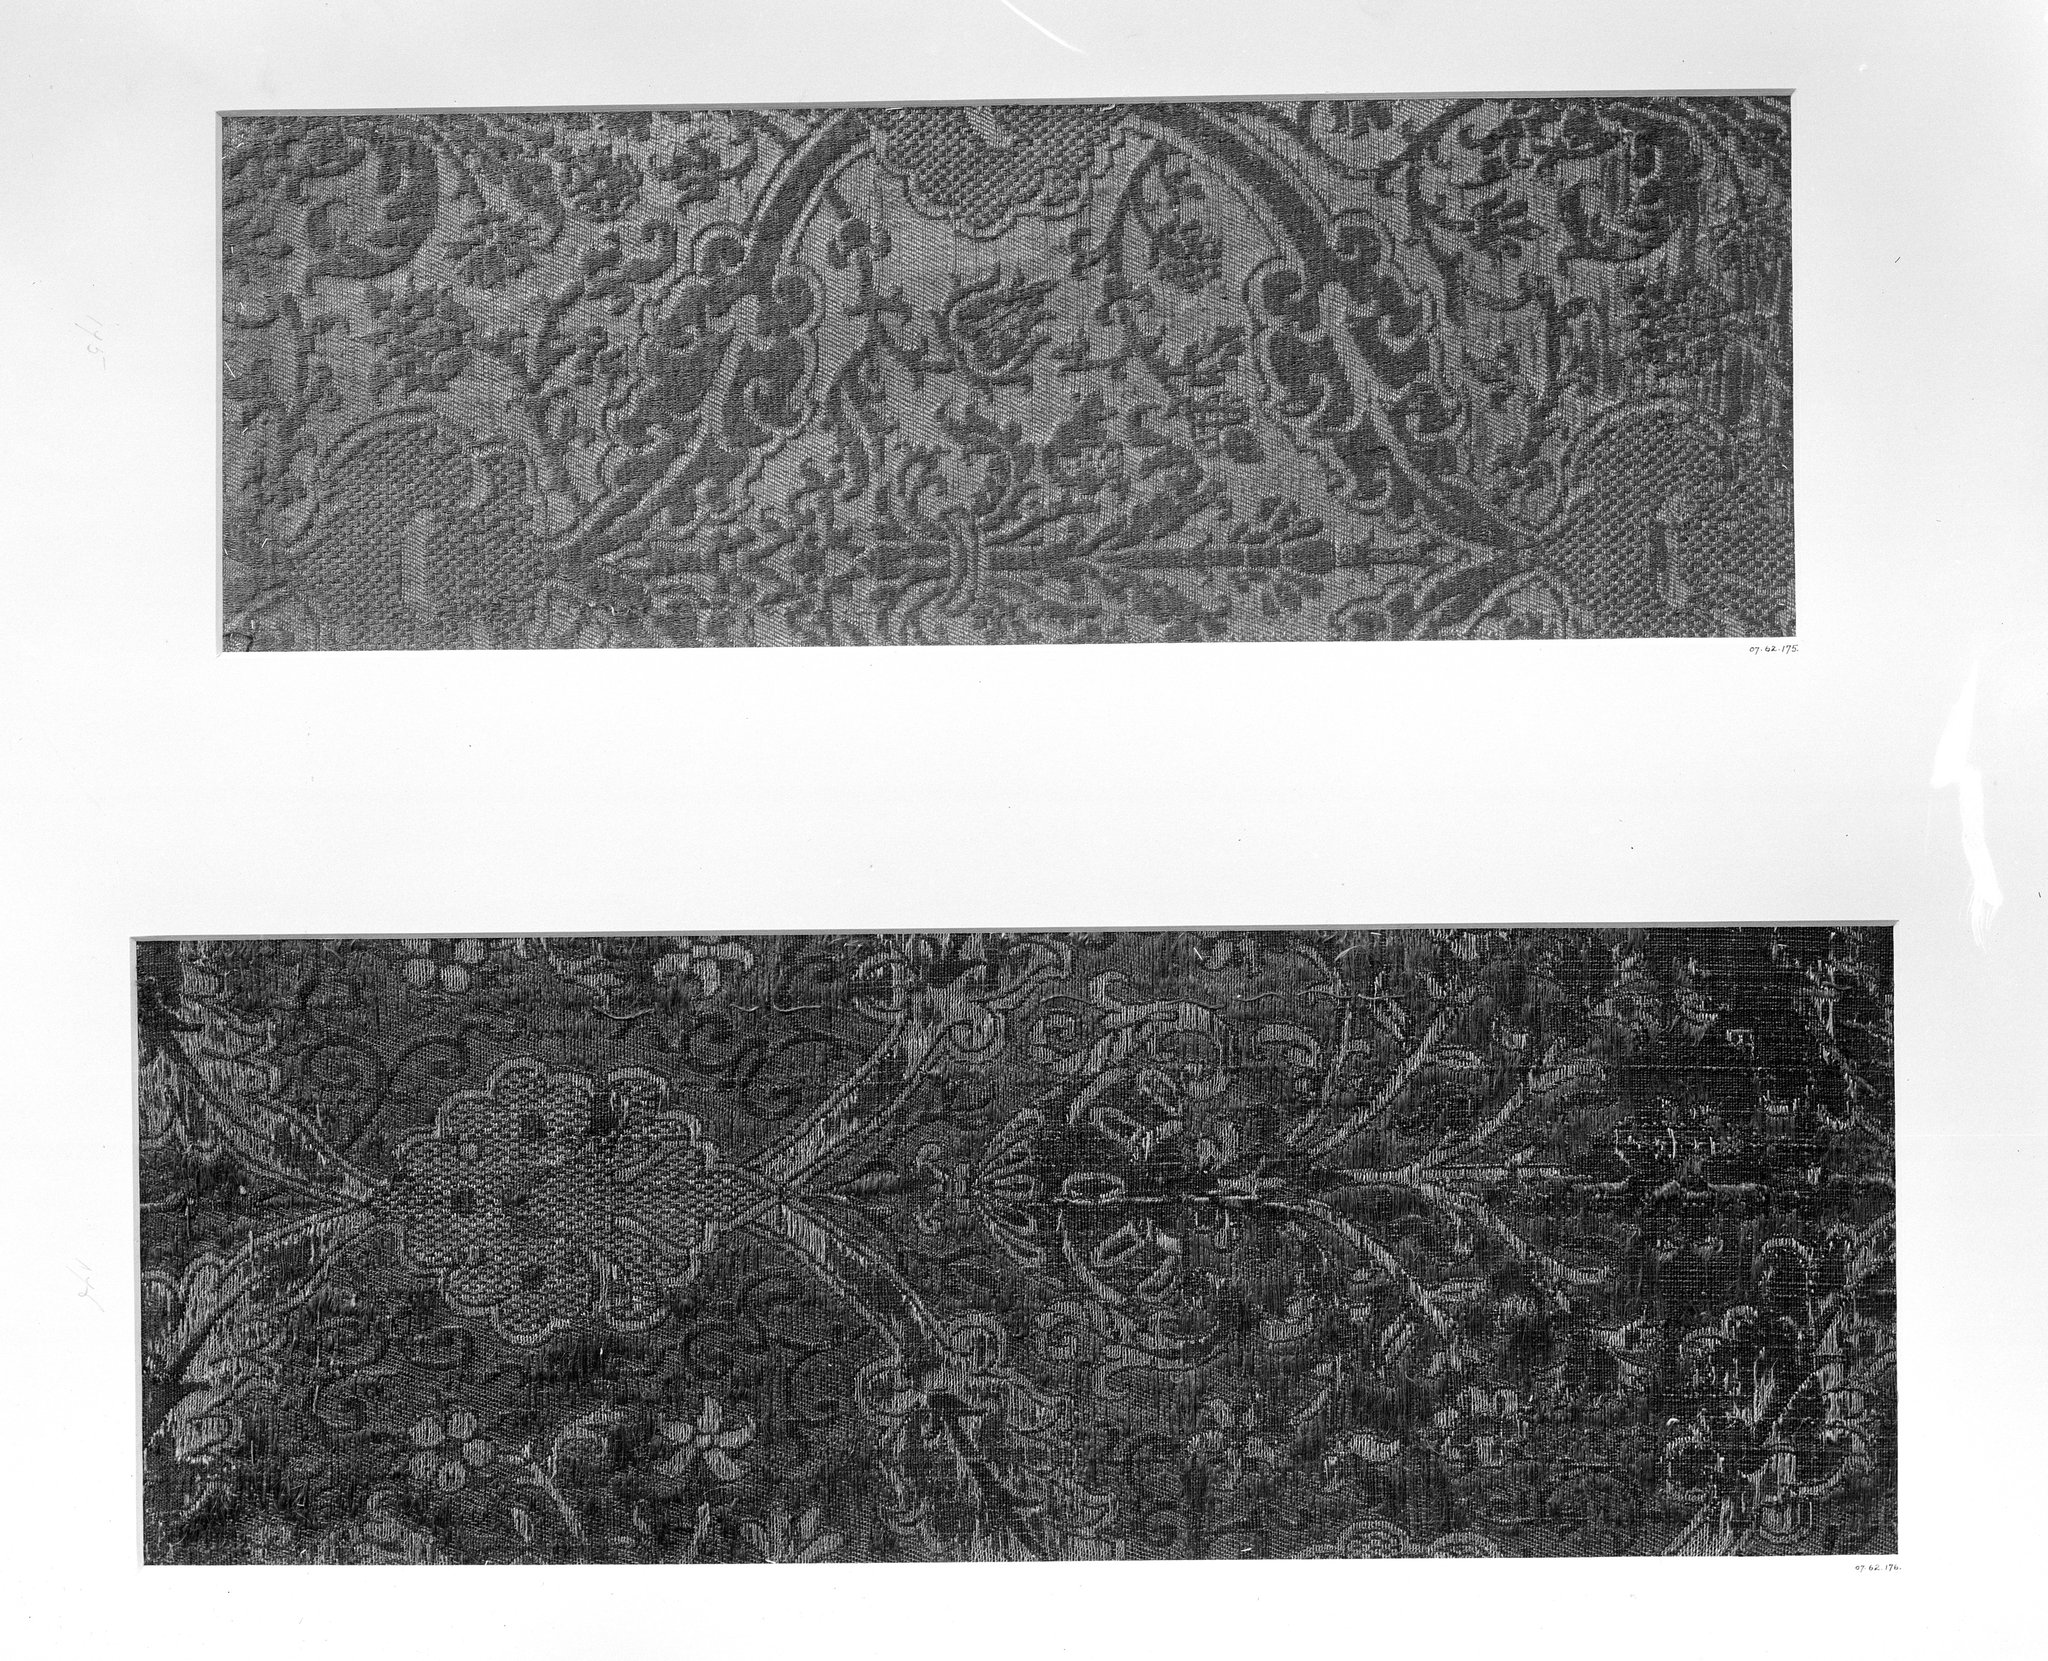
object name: piece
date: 1501-1600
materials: linen, metal thread, silk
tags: flowers,leaves